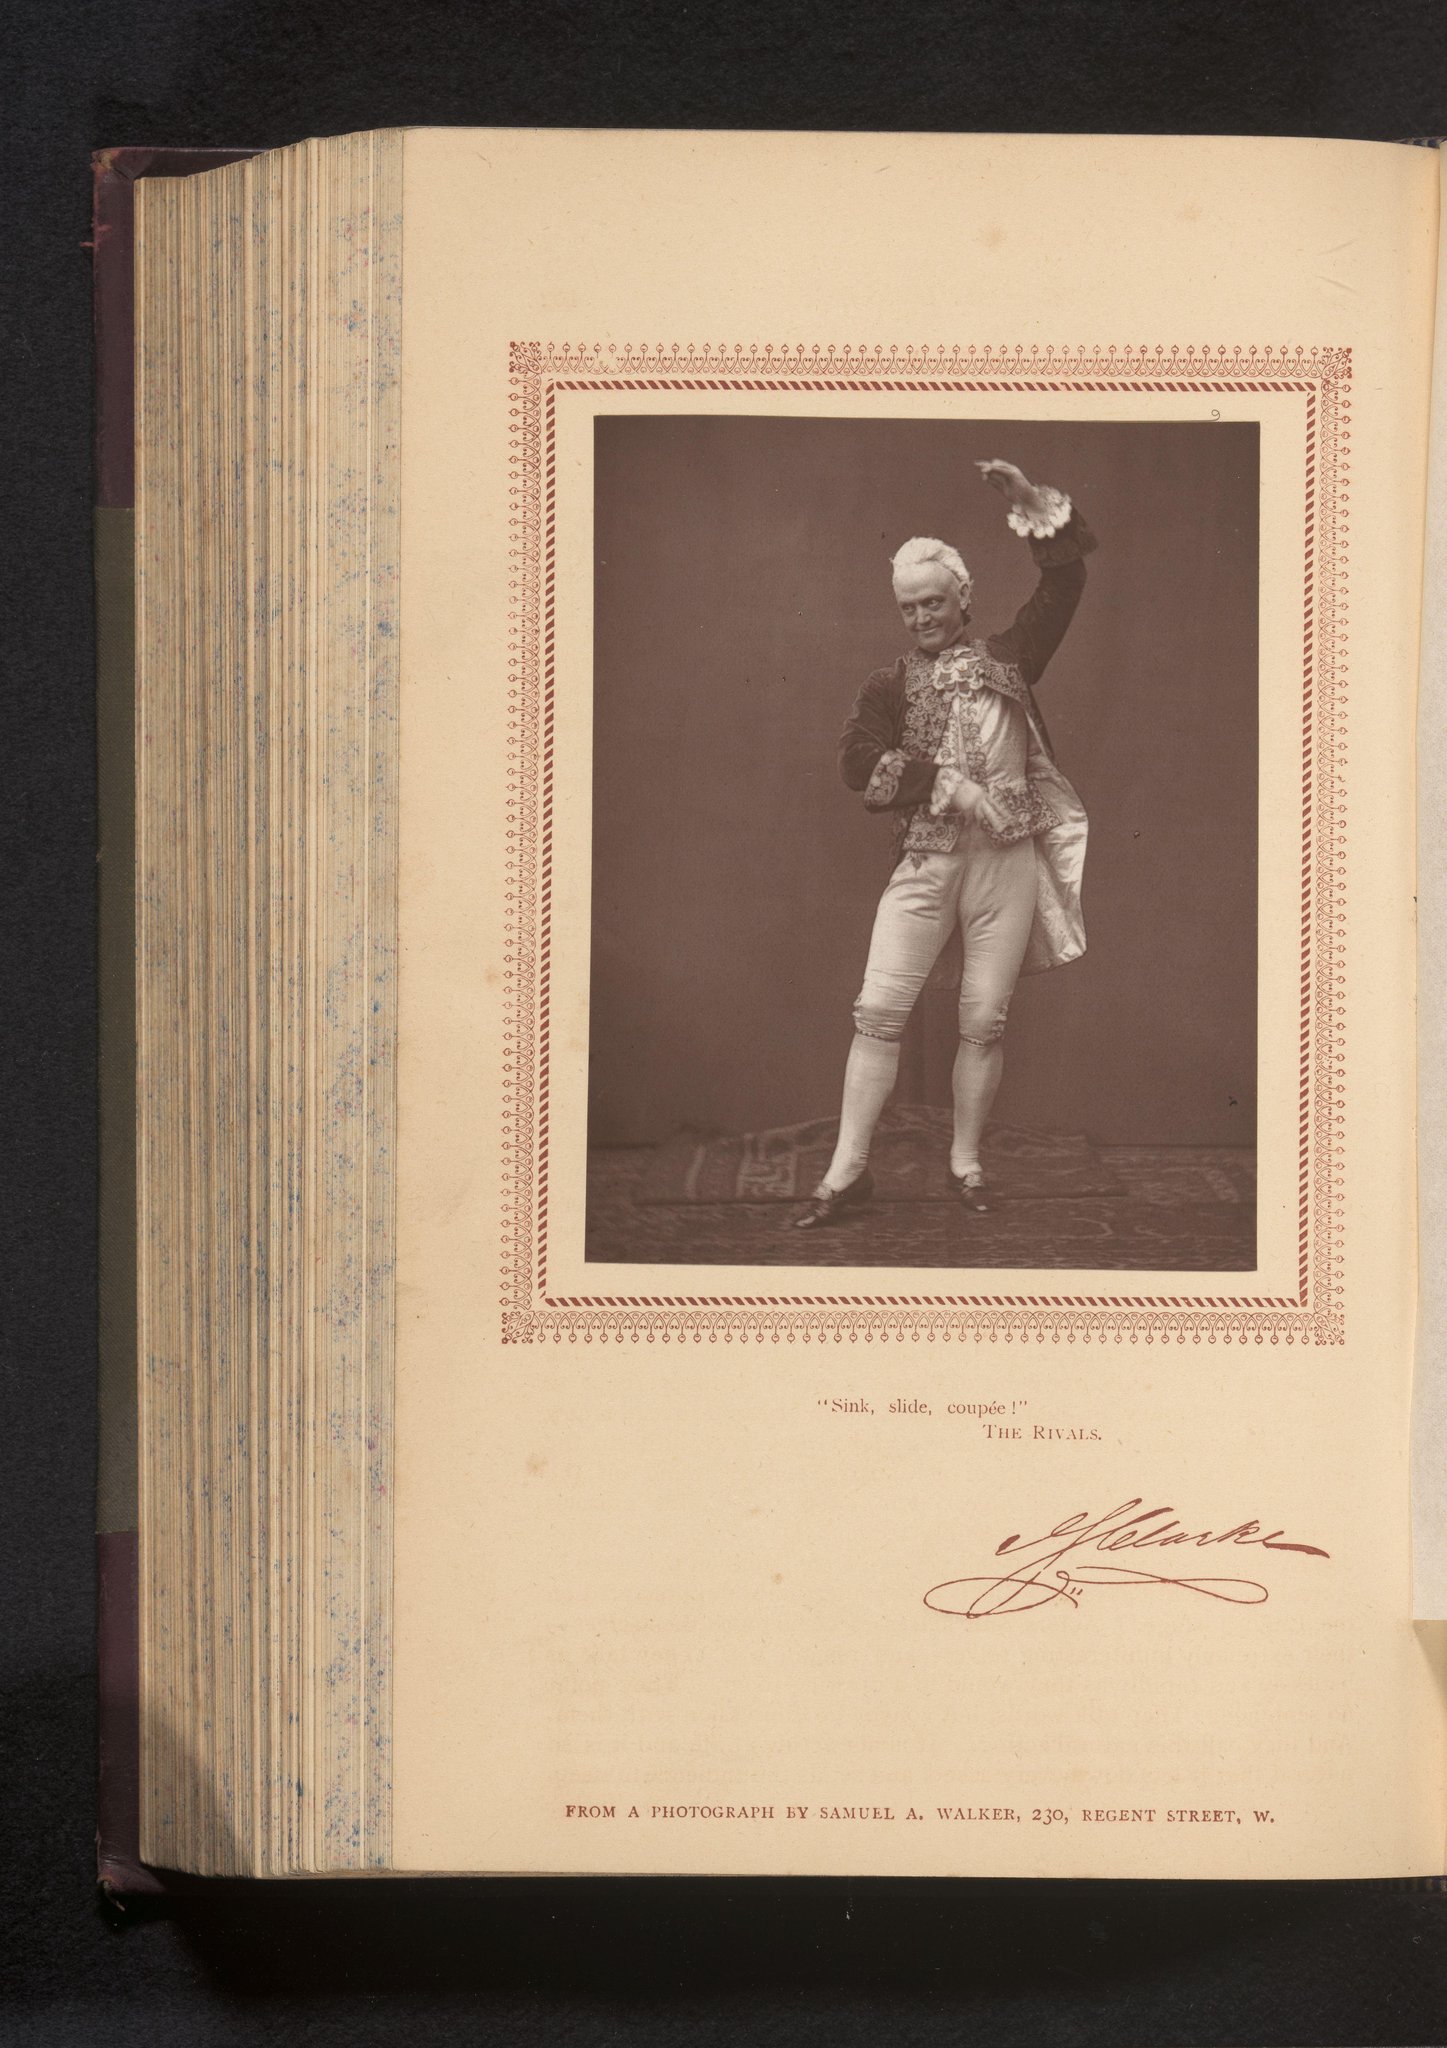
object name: page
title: Portret van John S. Clarke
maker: samuel alexander walker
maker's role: fotograaf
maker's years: 1841-1922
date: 1880-1885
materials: paper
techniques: woodburytype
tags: adult man, historical persons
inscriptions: signature: ‘J Clarke’, inscription: ‘'Sink, Slide, coupée!'/ The Rivals’